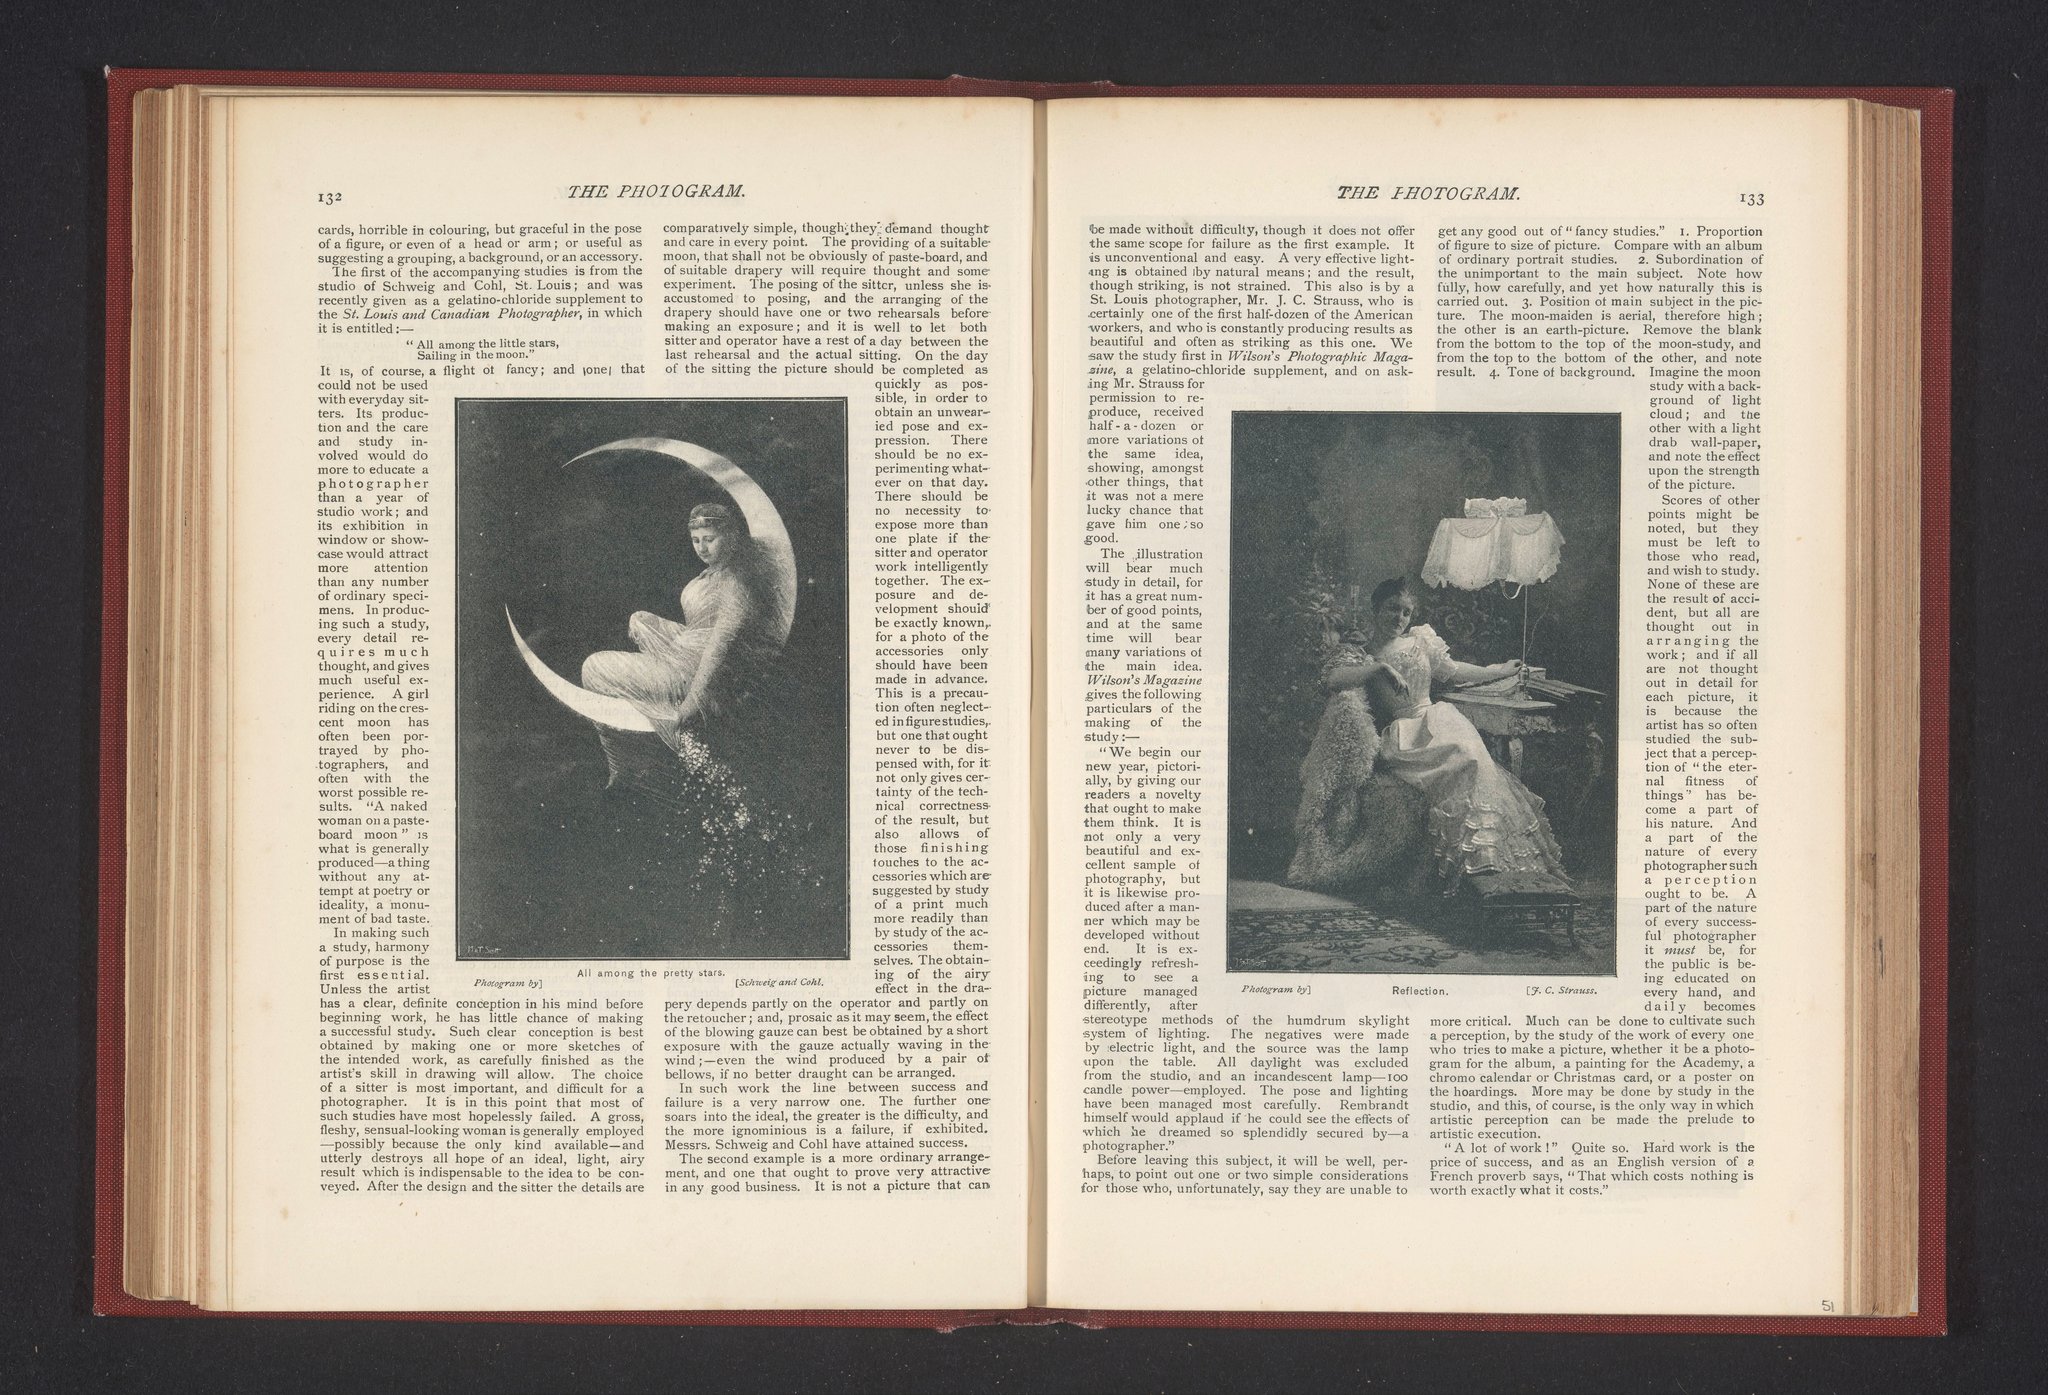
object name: page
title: Portret van een onbekende vrouw in een jurk aan een bureau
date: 1889-1894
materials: paper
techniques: autotype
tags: writing-table, writing-desk, historical persons - bb - woman